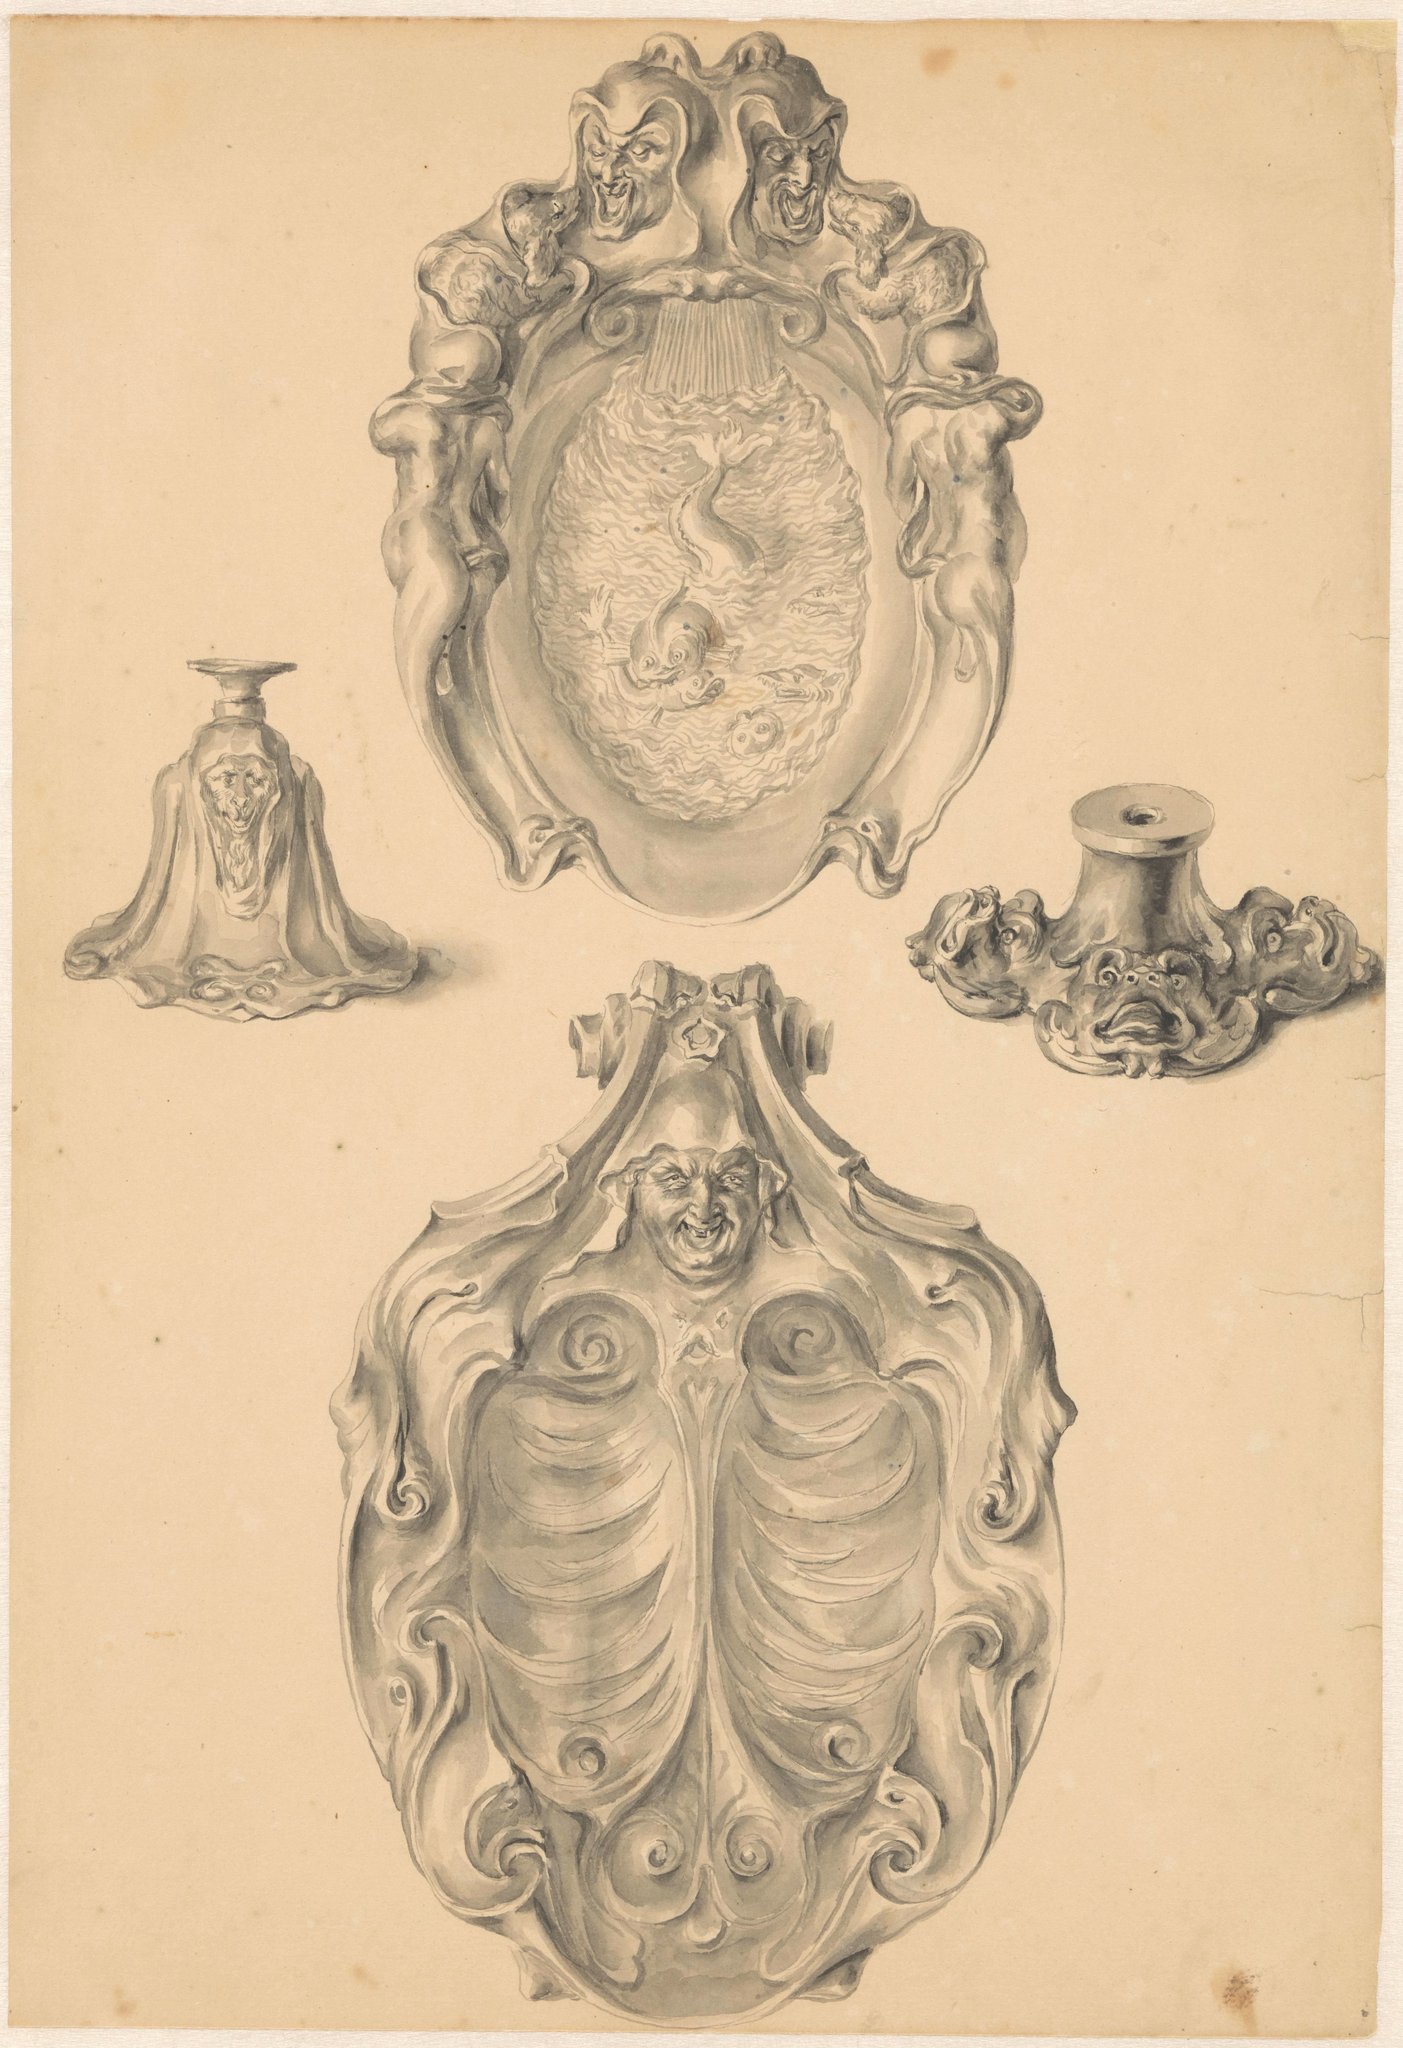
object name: album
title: Tekening van 17e eeuws zilver behorende bij een album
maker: Anonymous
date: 1725-1728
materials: paper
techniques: drawing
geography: amsterdam